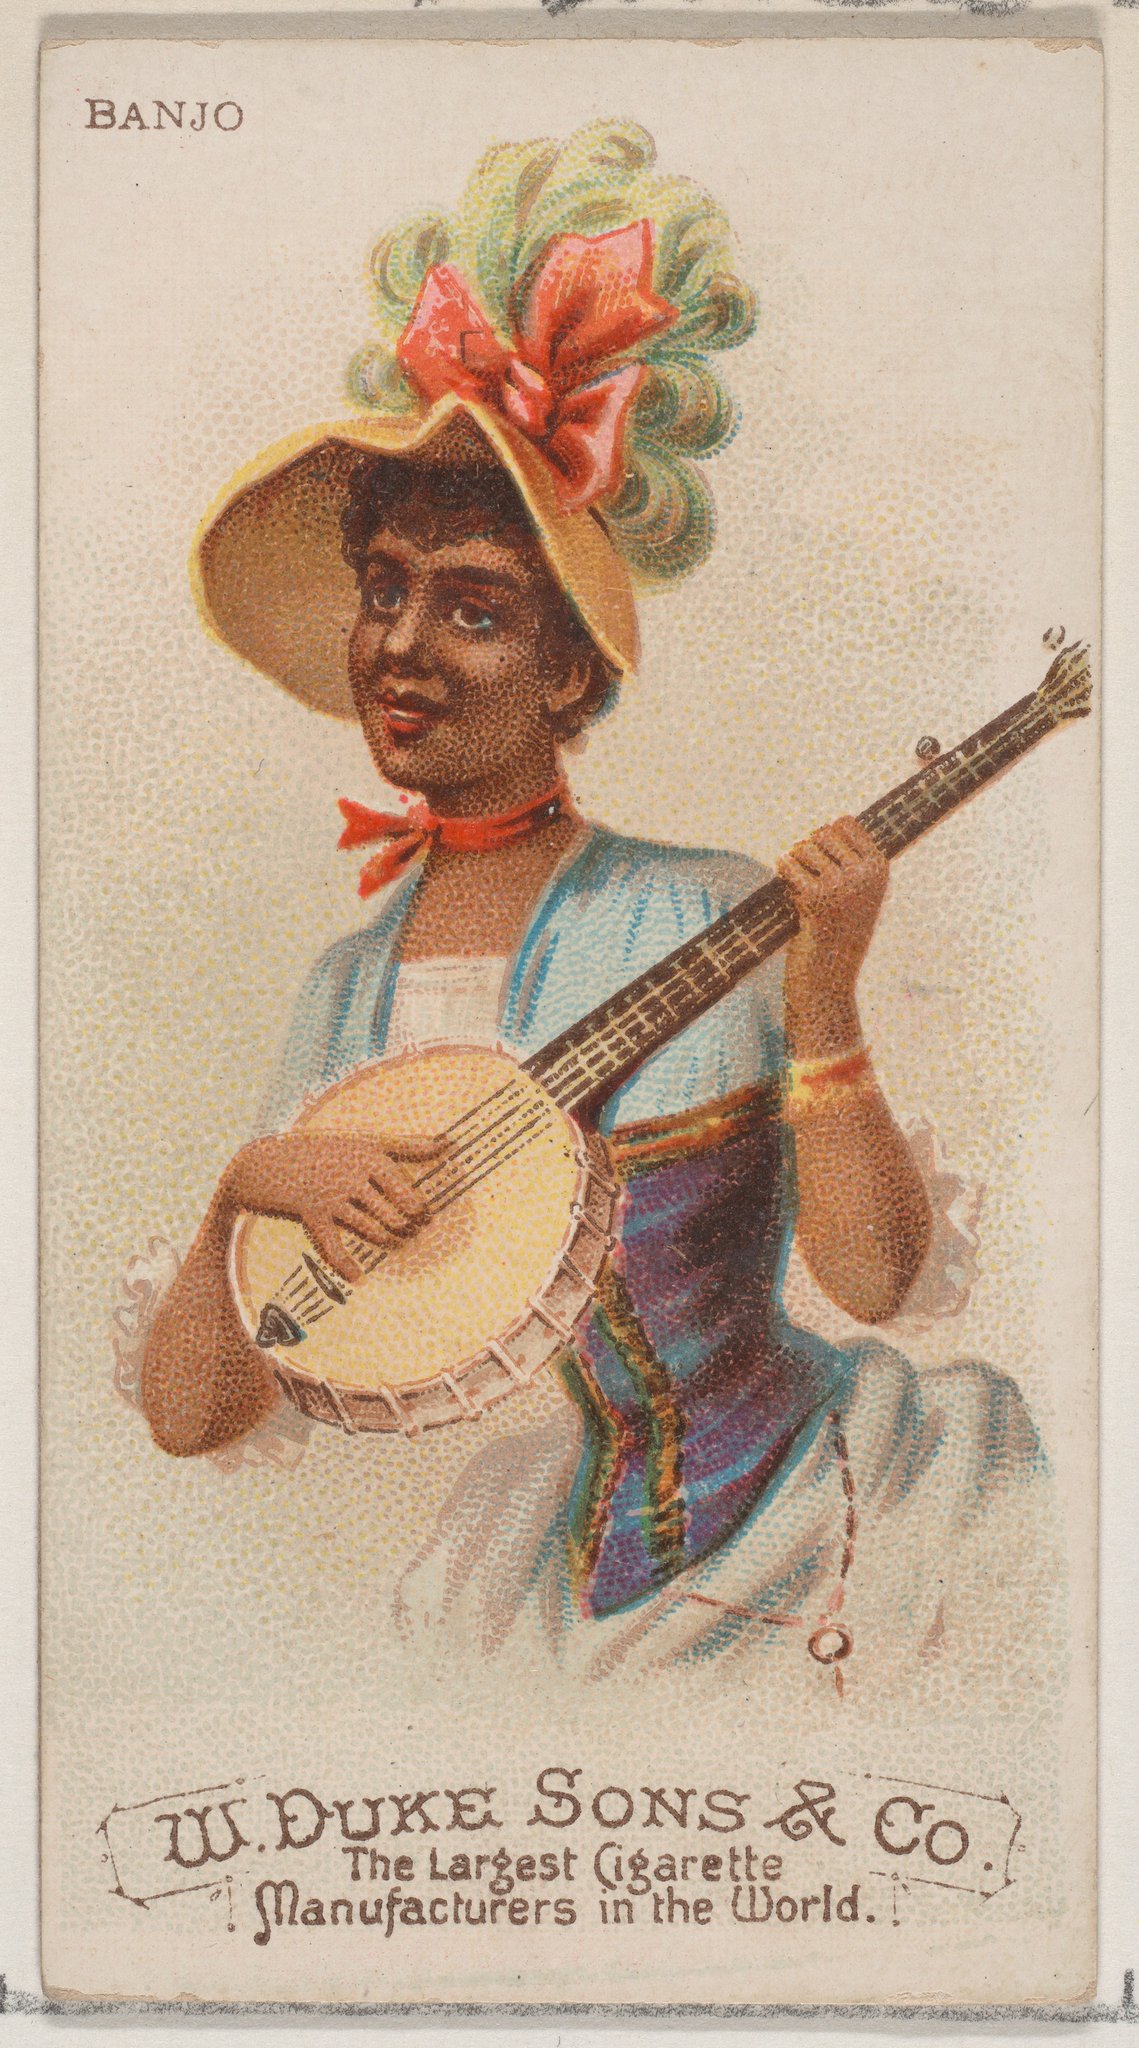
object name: print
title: Banjo, from the Musical Instruments series (N82) for Duke brand cigarettes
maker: w. duke, sons & co.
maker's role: publisher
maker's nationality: american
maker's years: 1870-1920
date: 1888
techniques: color lithograph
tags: musical instruments,women,musicians